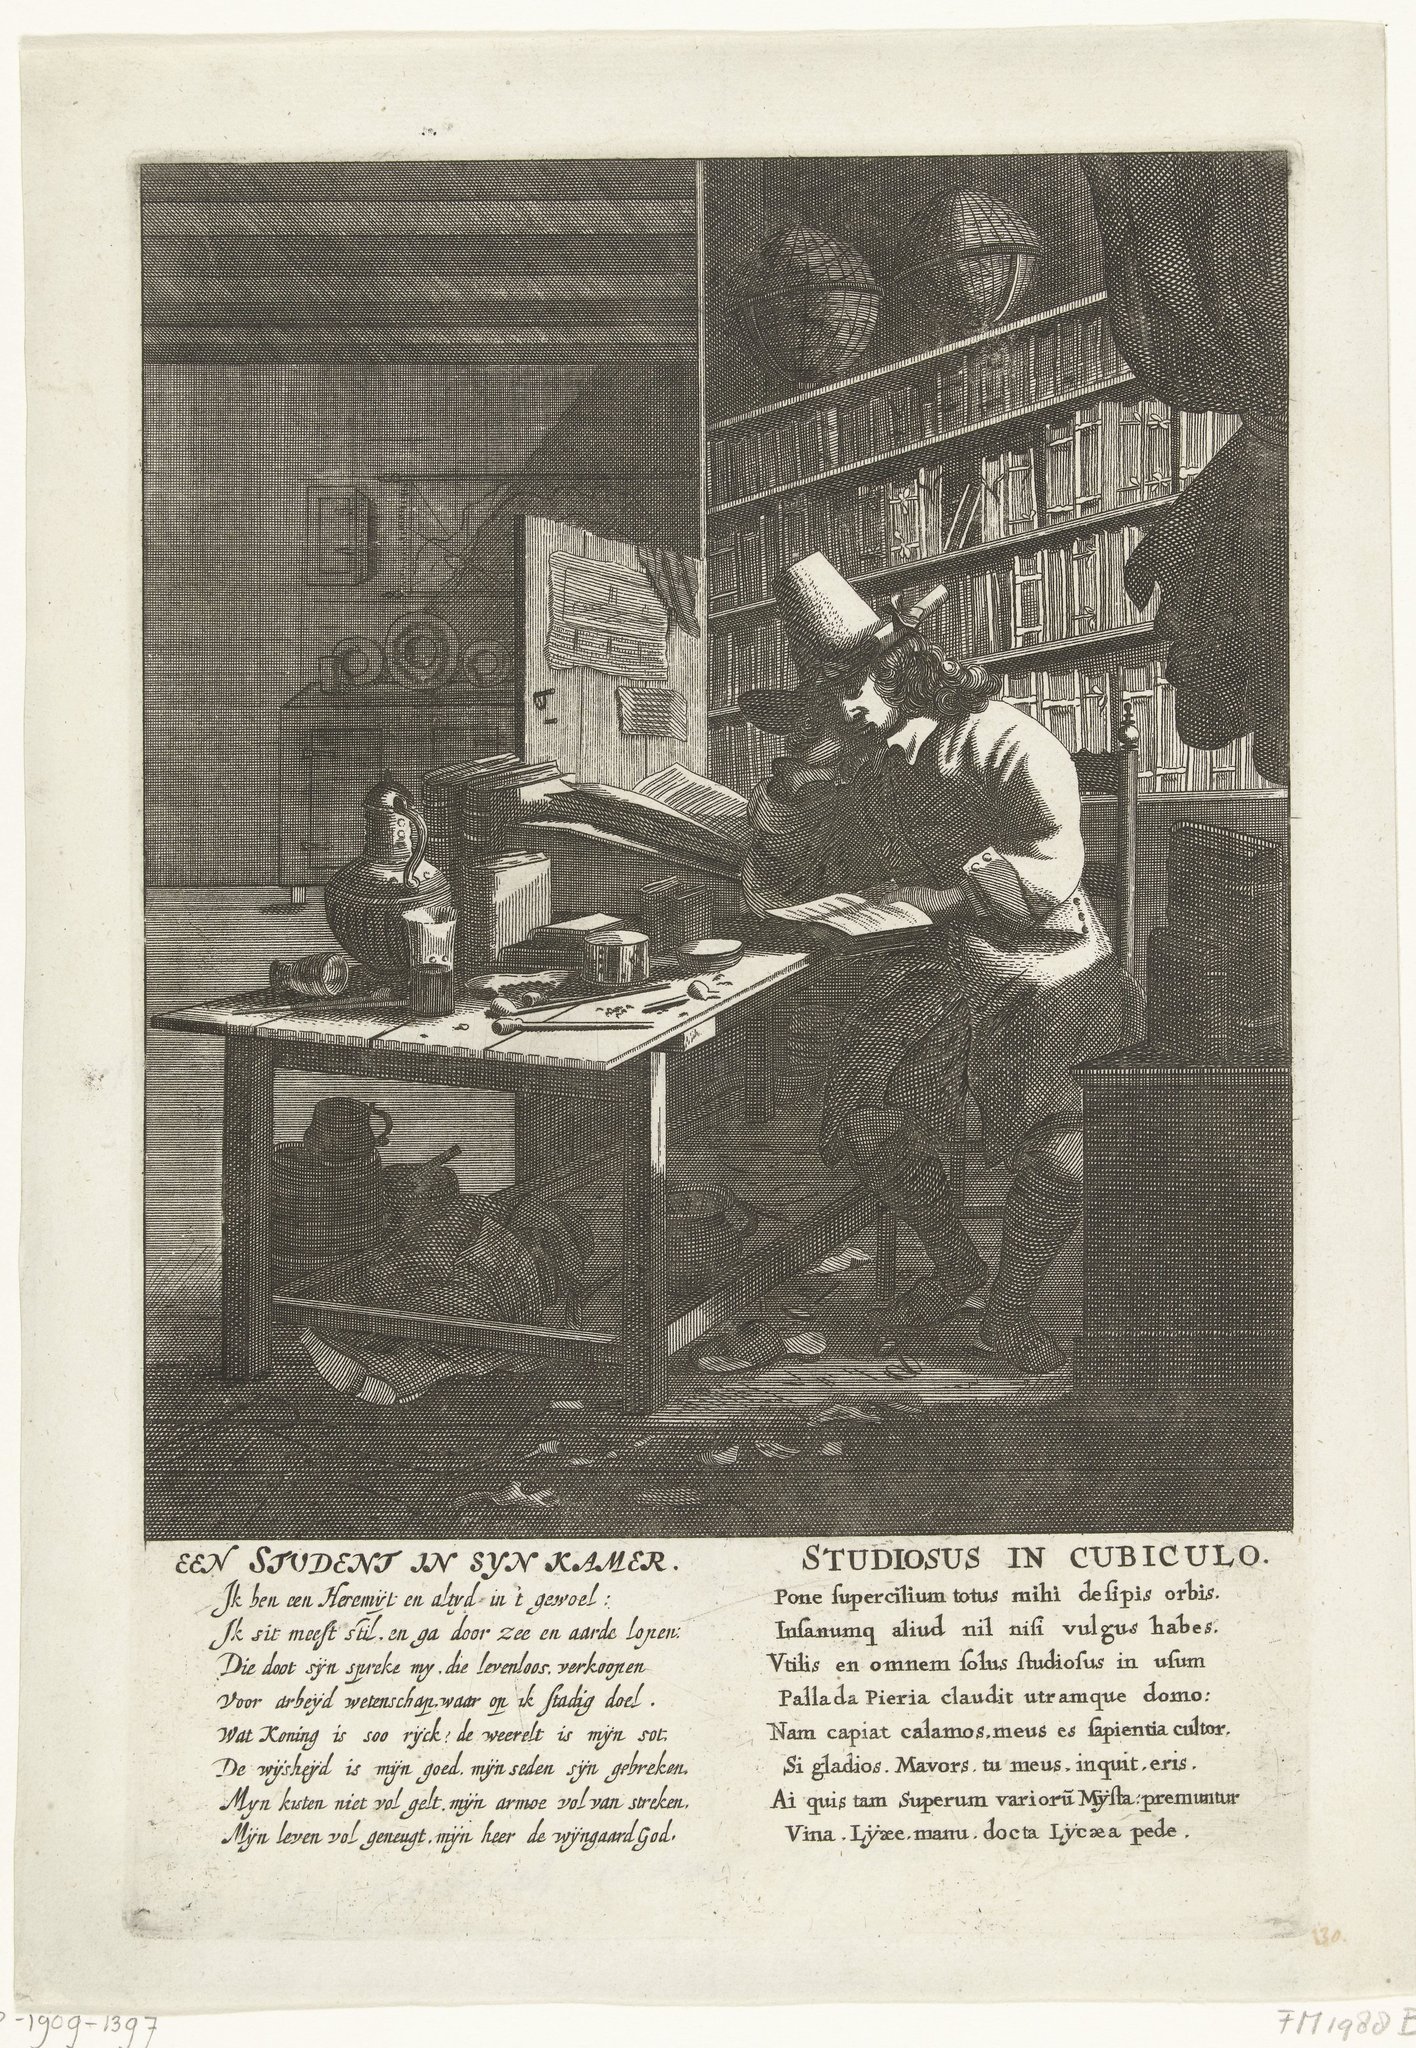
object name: print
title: Student op zijn kamer, ca. 1650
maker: Anonymous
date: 1640-1660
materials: paper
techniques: etching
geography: northern netherlands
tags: student room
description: Een student op zijn kamer, zittend aan tafel lezend in een boek. Op de achtergrond een volle boekenkast met bovenop twee globes. Op de studeertafel boeken, pijpen, glazen en een kruik. In het onderschrift 2 verzen van 8 regels in het Nederlands en Latijn.